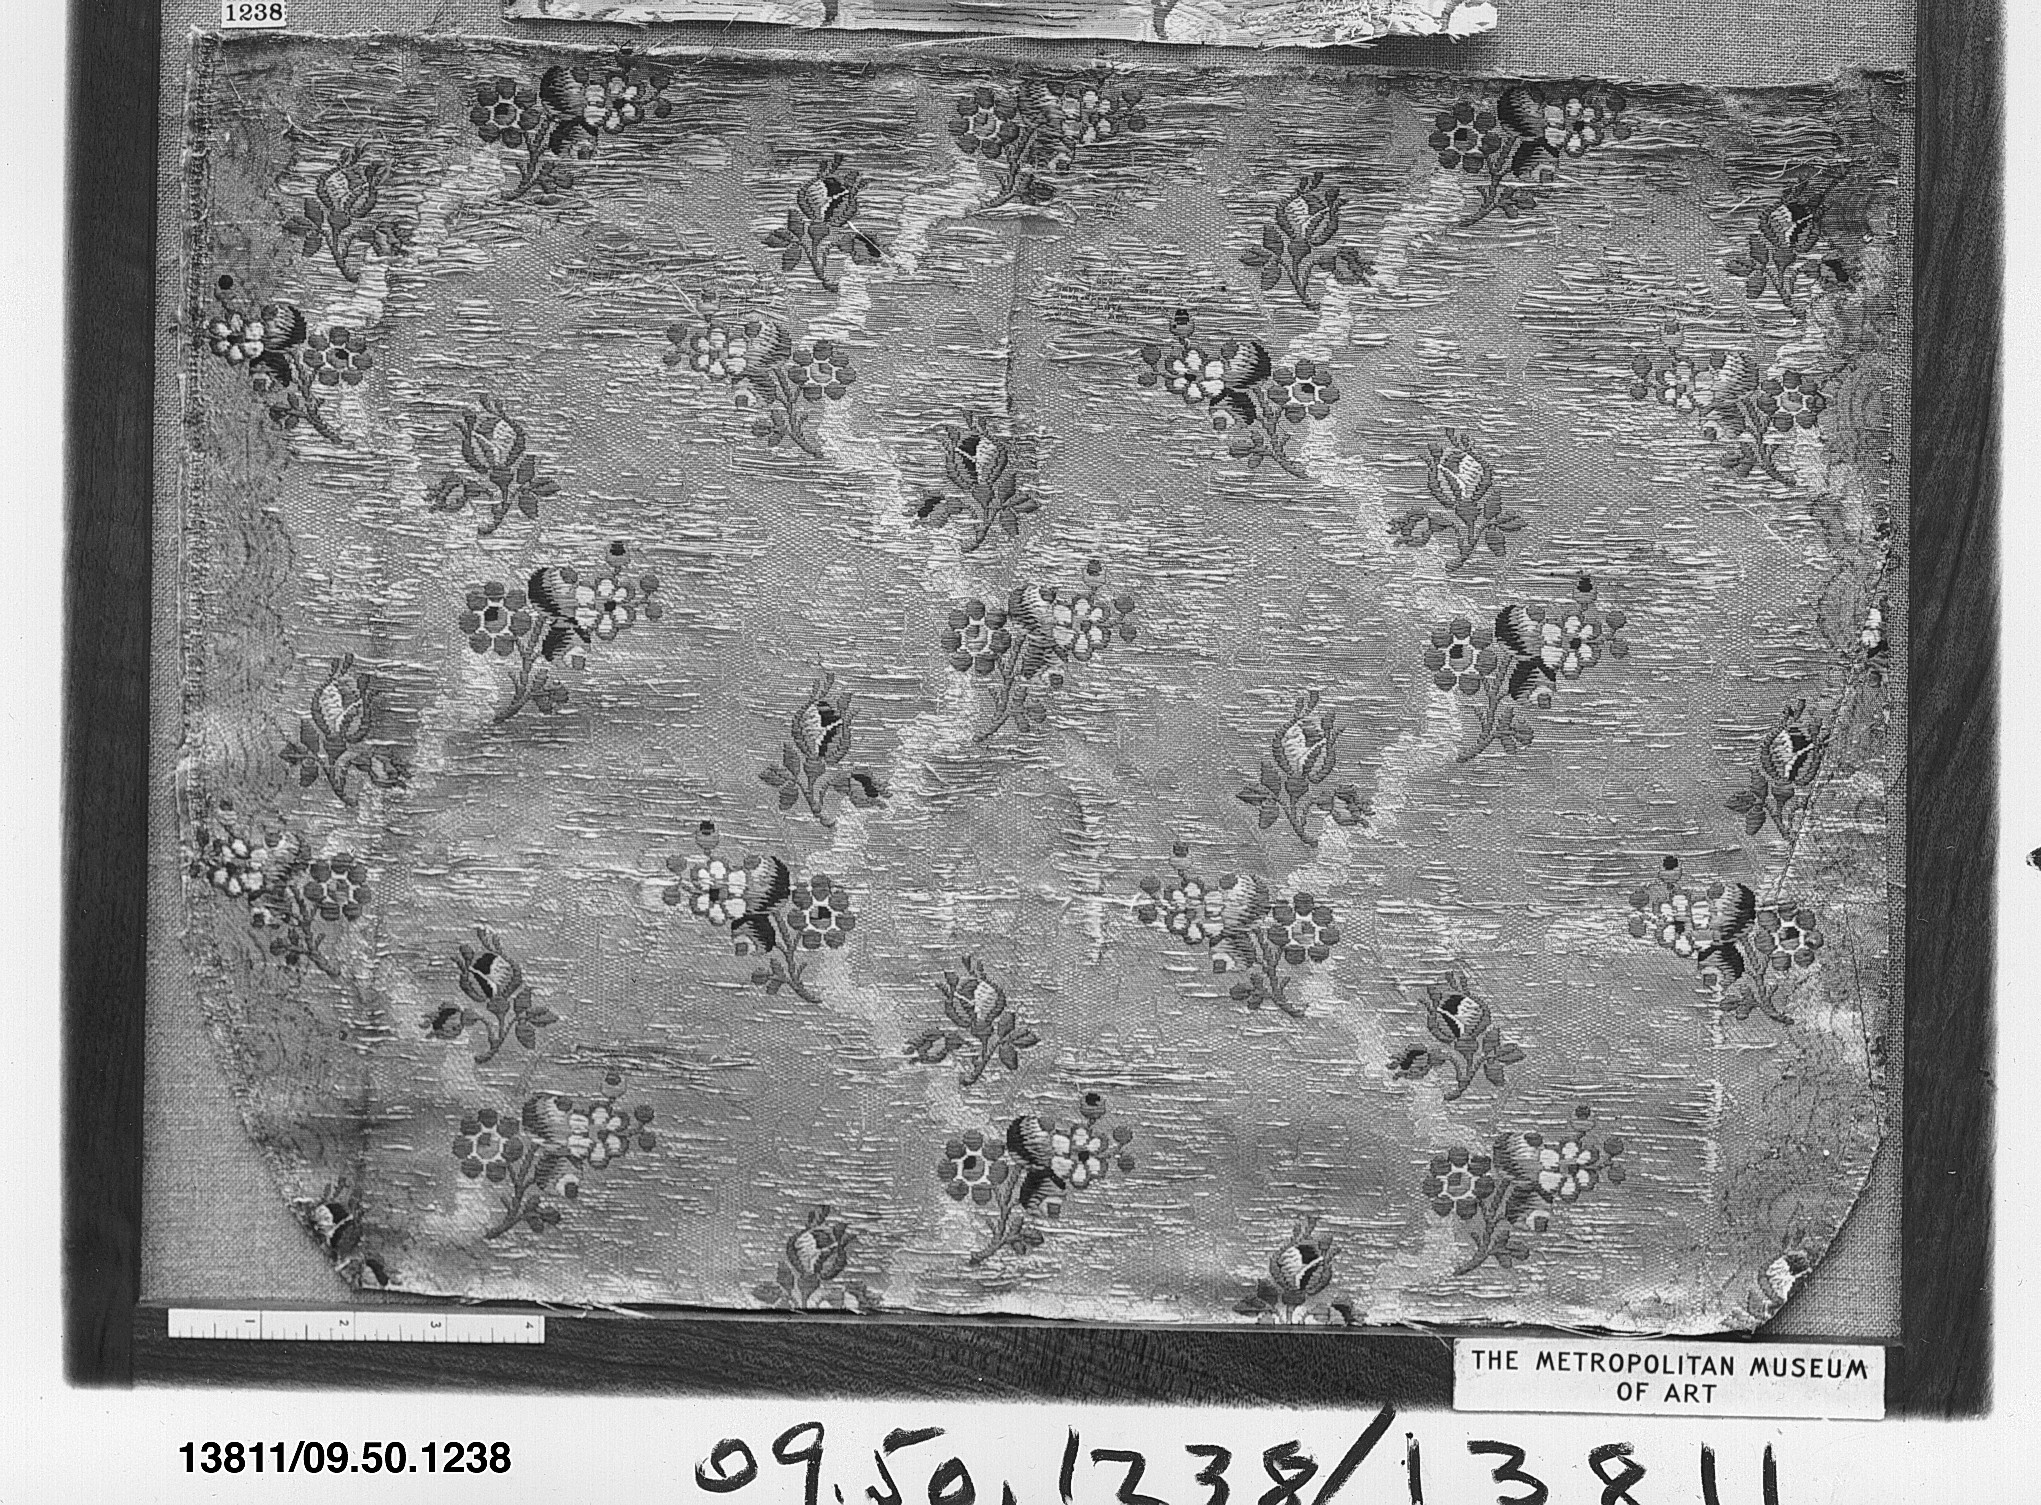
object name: piece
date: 1701-1800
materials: metal thread, silk